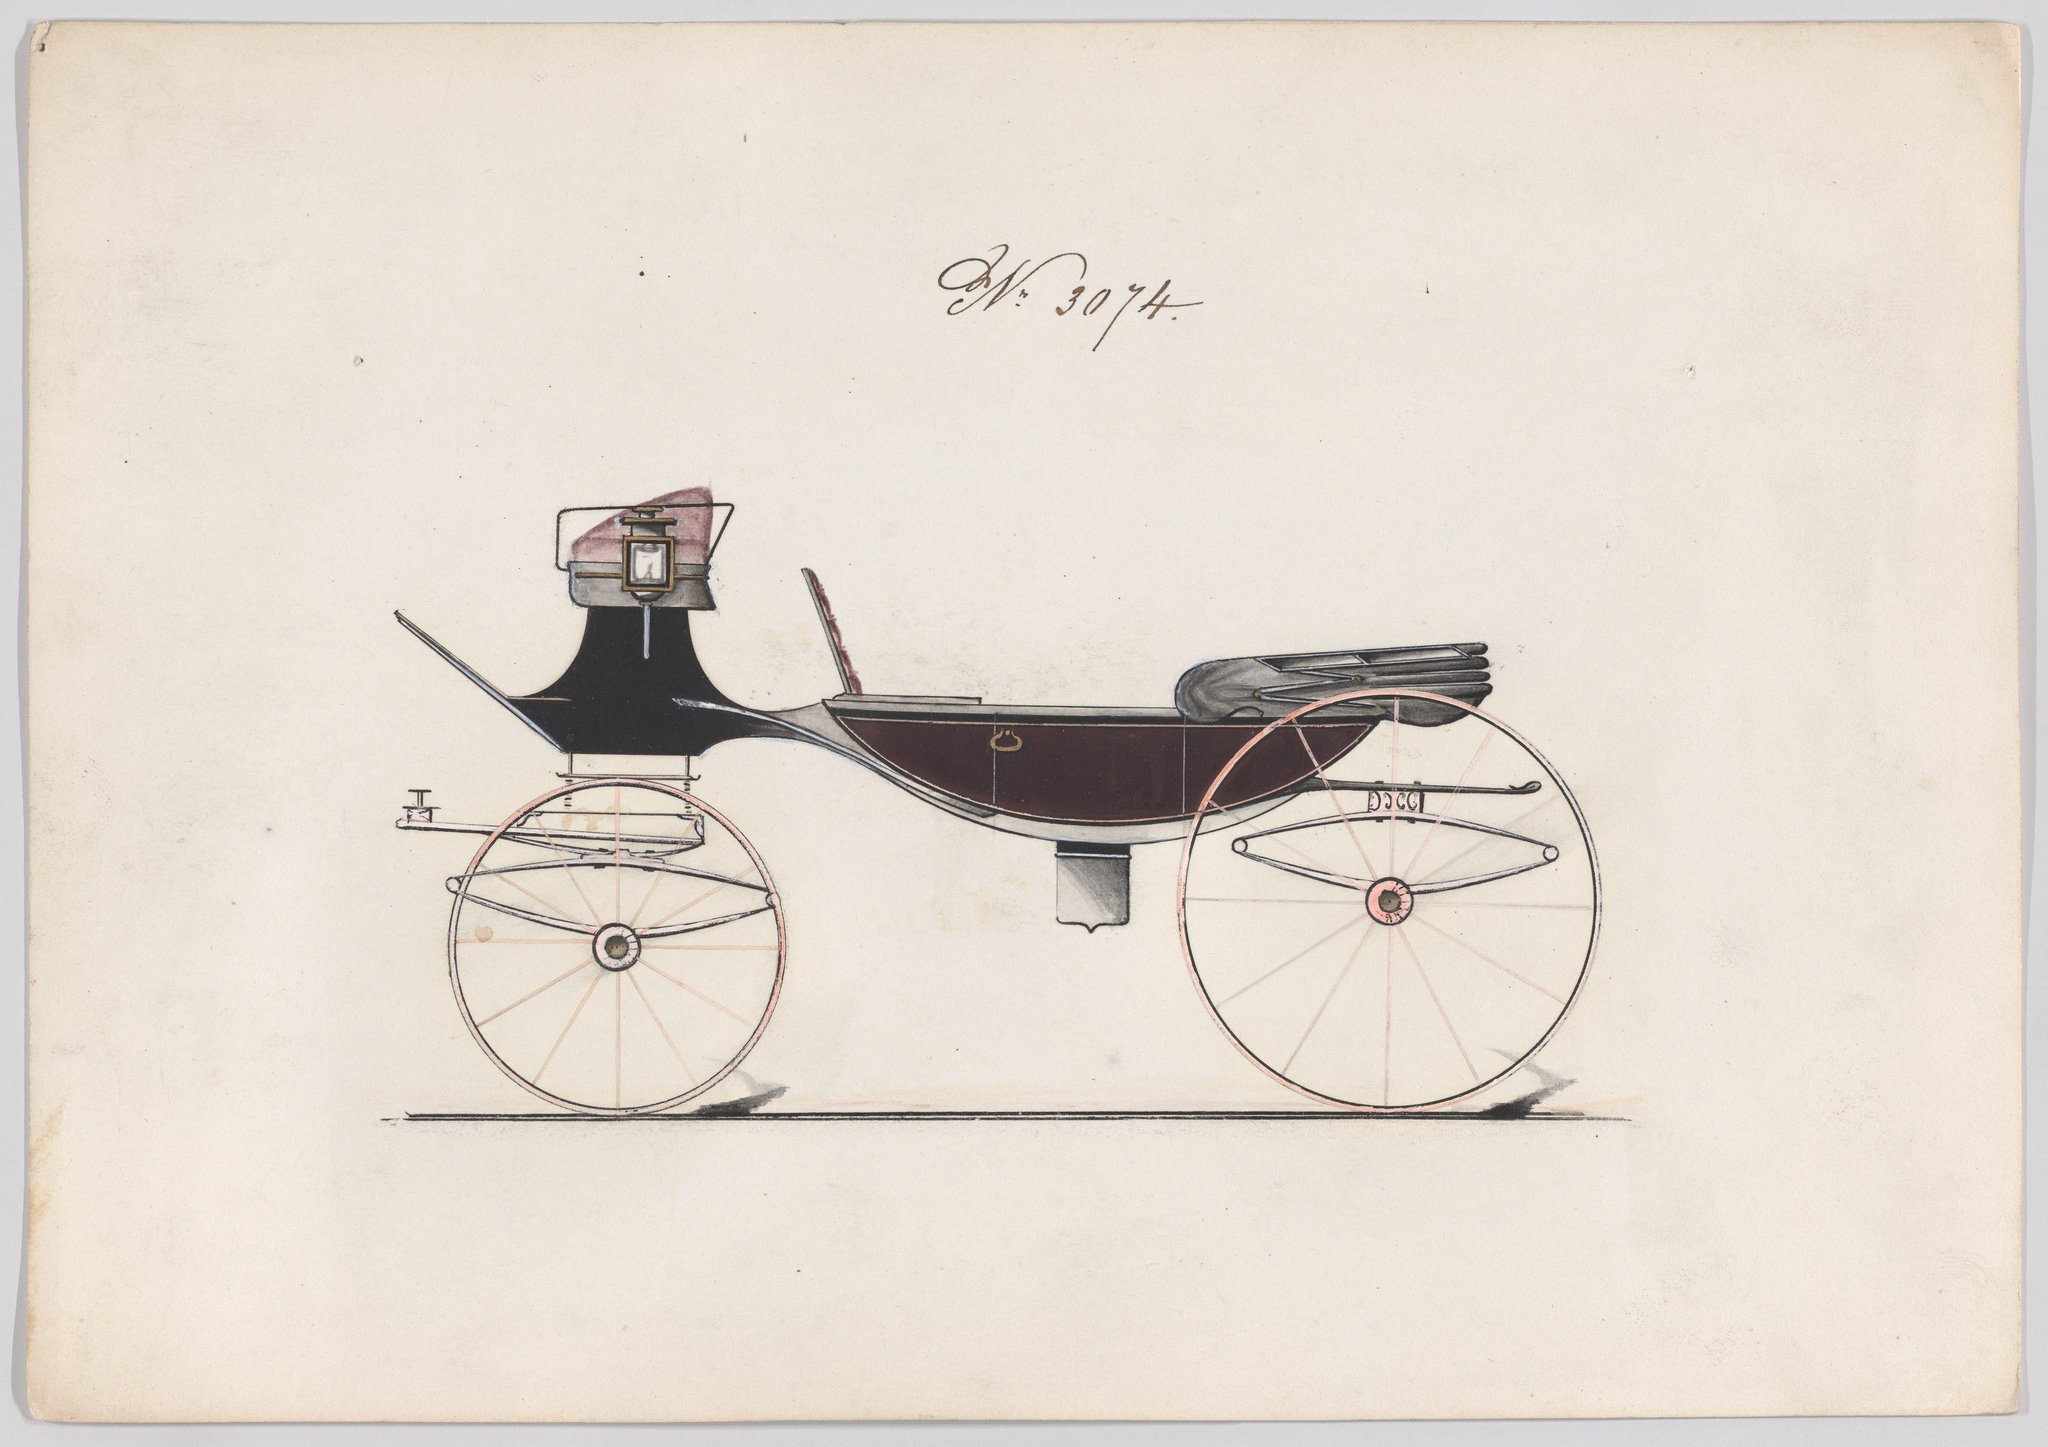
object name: drawing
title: Vis-à-vis/Brett #3074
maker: brewster & co.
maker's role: manufacturer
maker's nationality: american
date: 1874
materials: gouache, gum arabic, ink, watercolor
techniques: pen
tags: carriages